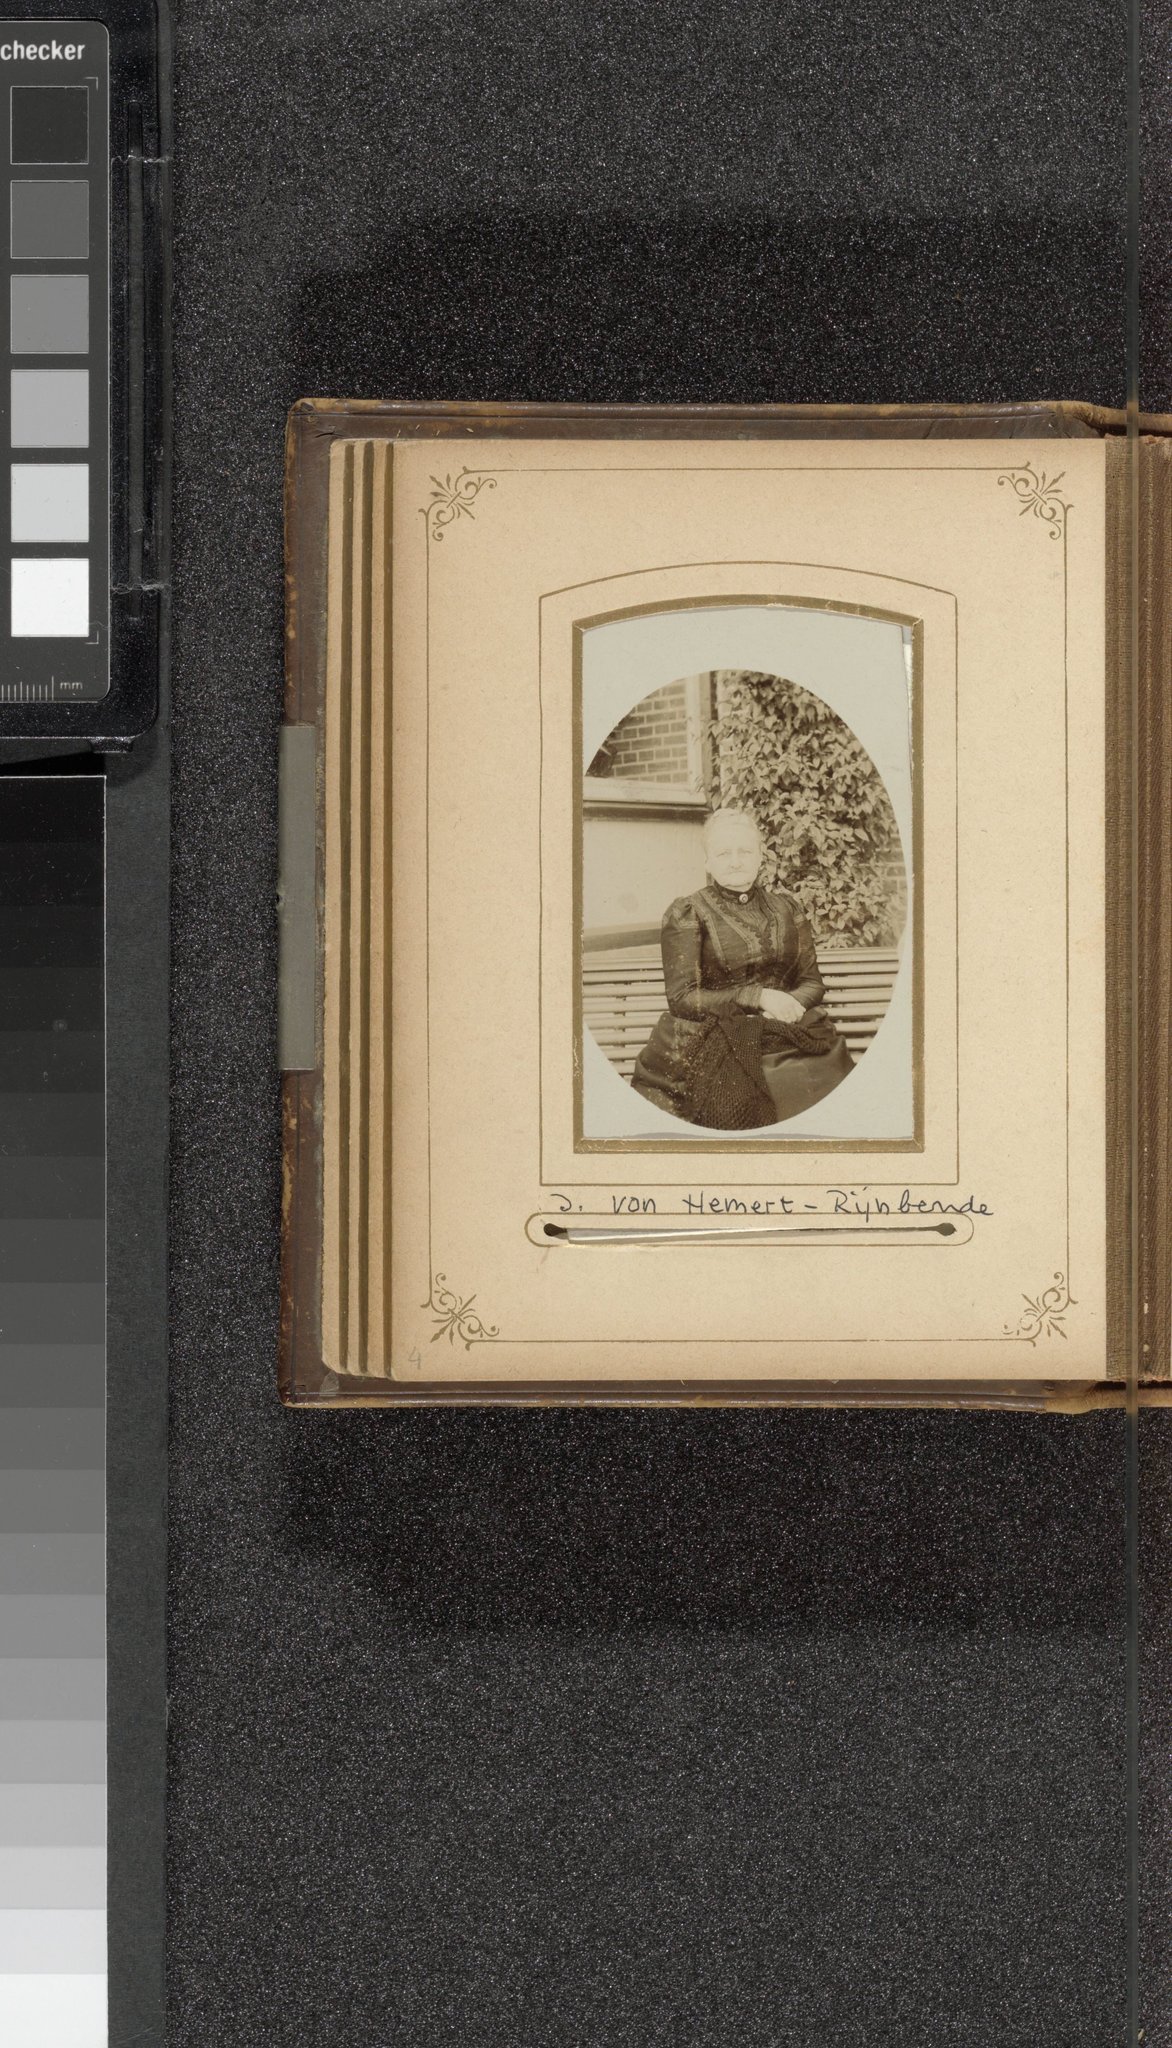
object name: carte de visite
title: Portret van J. von Hemert-Rijnbende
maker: Anonymous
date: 1903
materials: cardboard, paper, photographic support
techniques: gelatin silver print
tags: historical persons - bb - woman, dress, gown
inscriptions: name: ‘J. von Hemert-Rijnbende’, date: ‘1903’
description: Onderdeel van Fotoalbum van de families Boelen, Matthes en Pennink.